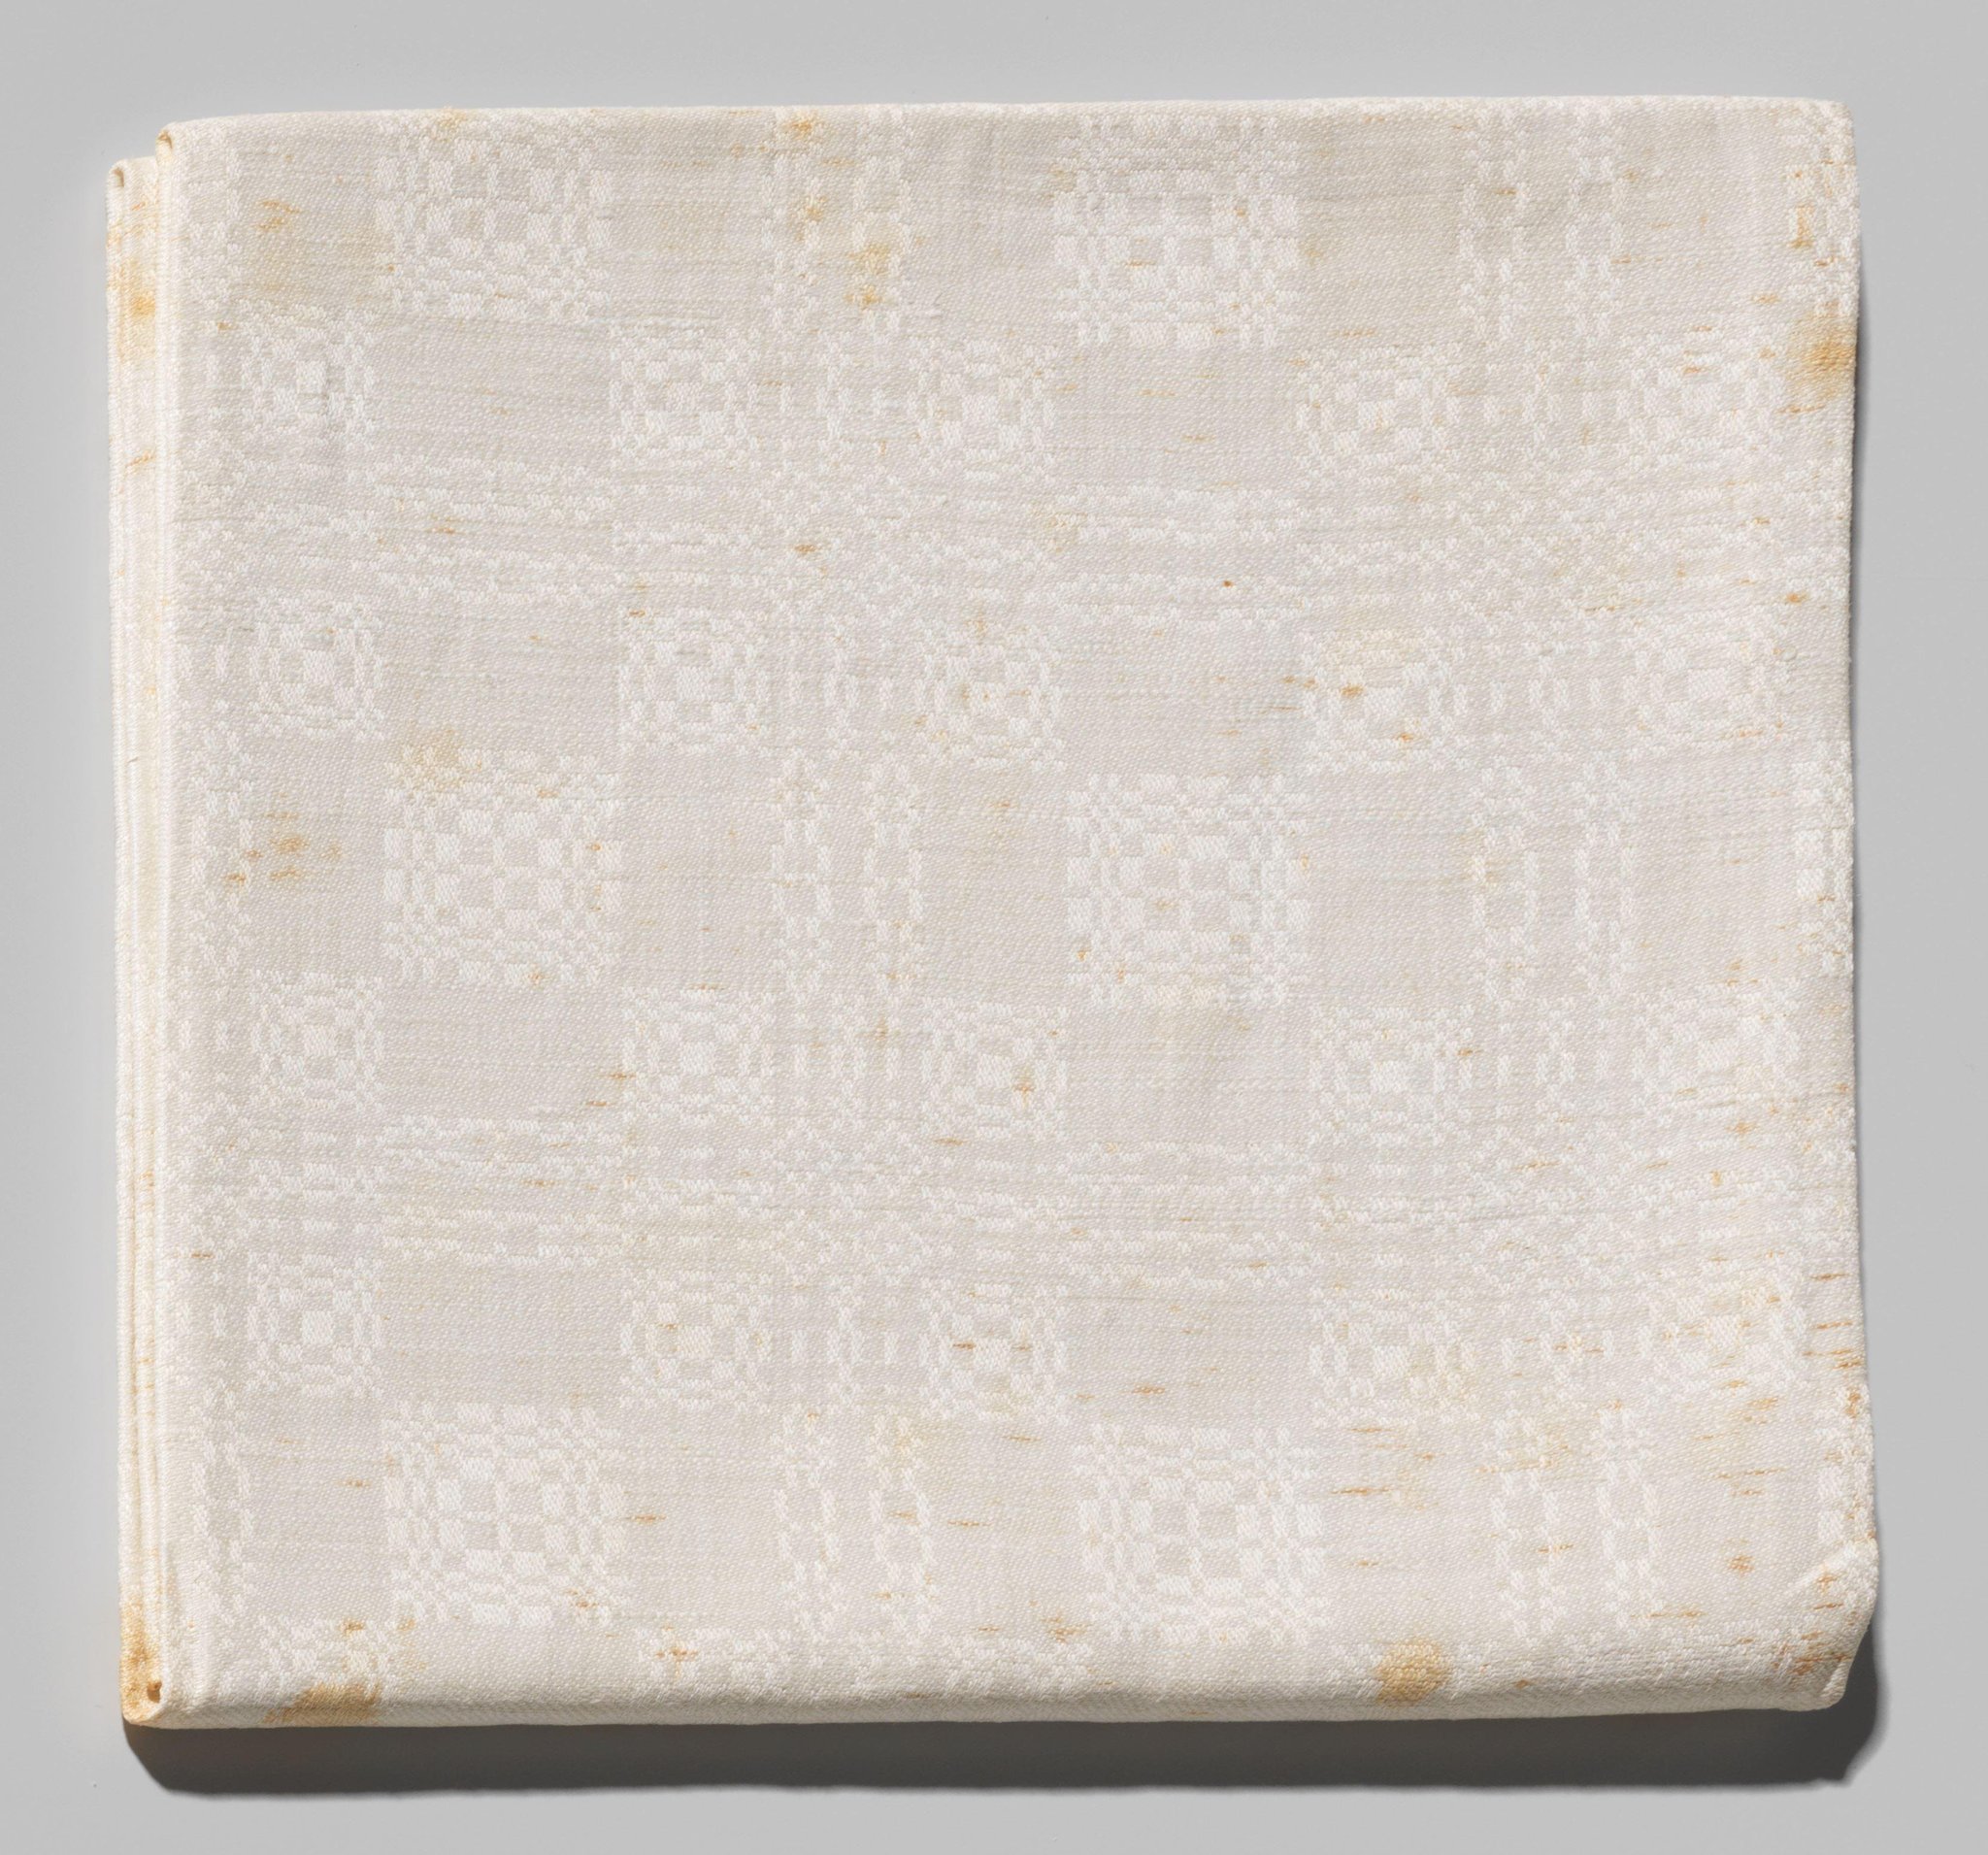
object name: napkin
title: Servet of dwaal met pellenpatroon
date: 1690-1700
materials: linen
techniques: peeled fabric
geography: netherlands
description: Servet of dwaal van wit linnendamast met een pellenpatroon: oneindig rapport van vierkanten, door dubbele lijsten omsloten en gevuld met vijf vierkanten met blok- en rechthoekvulling.